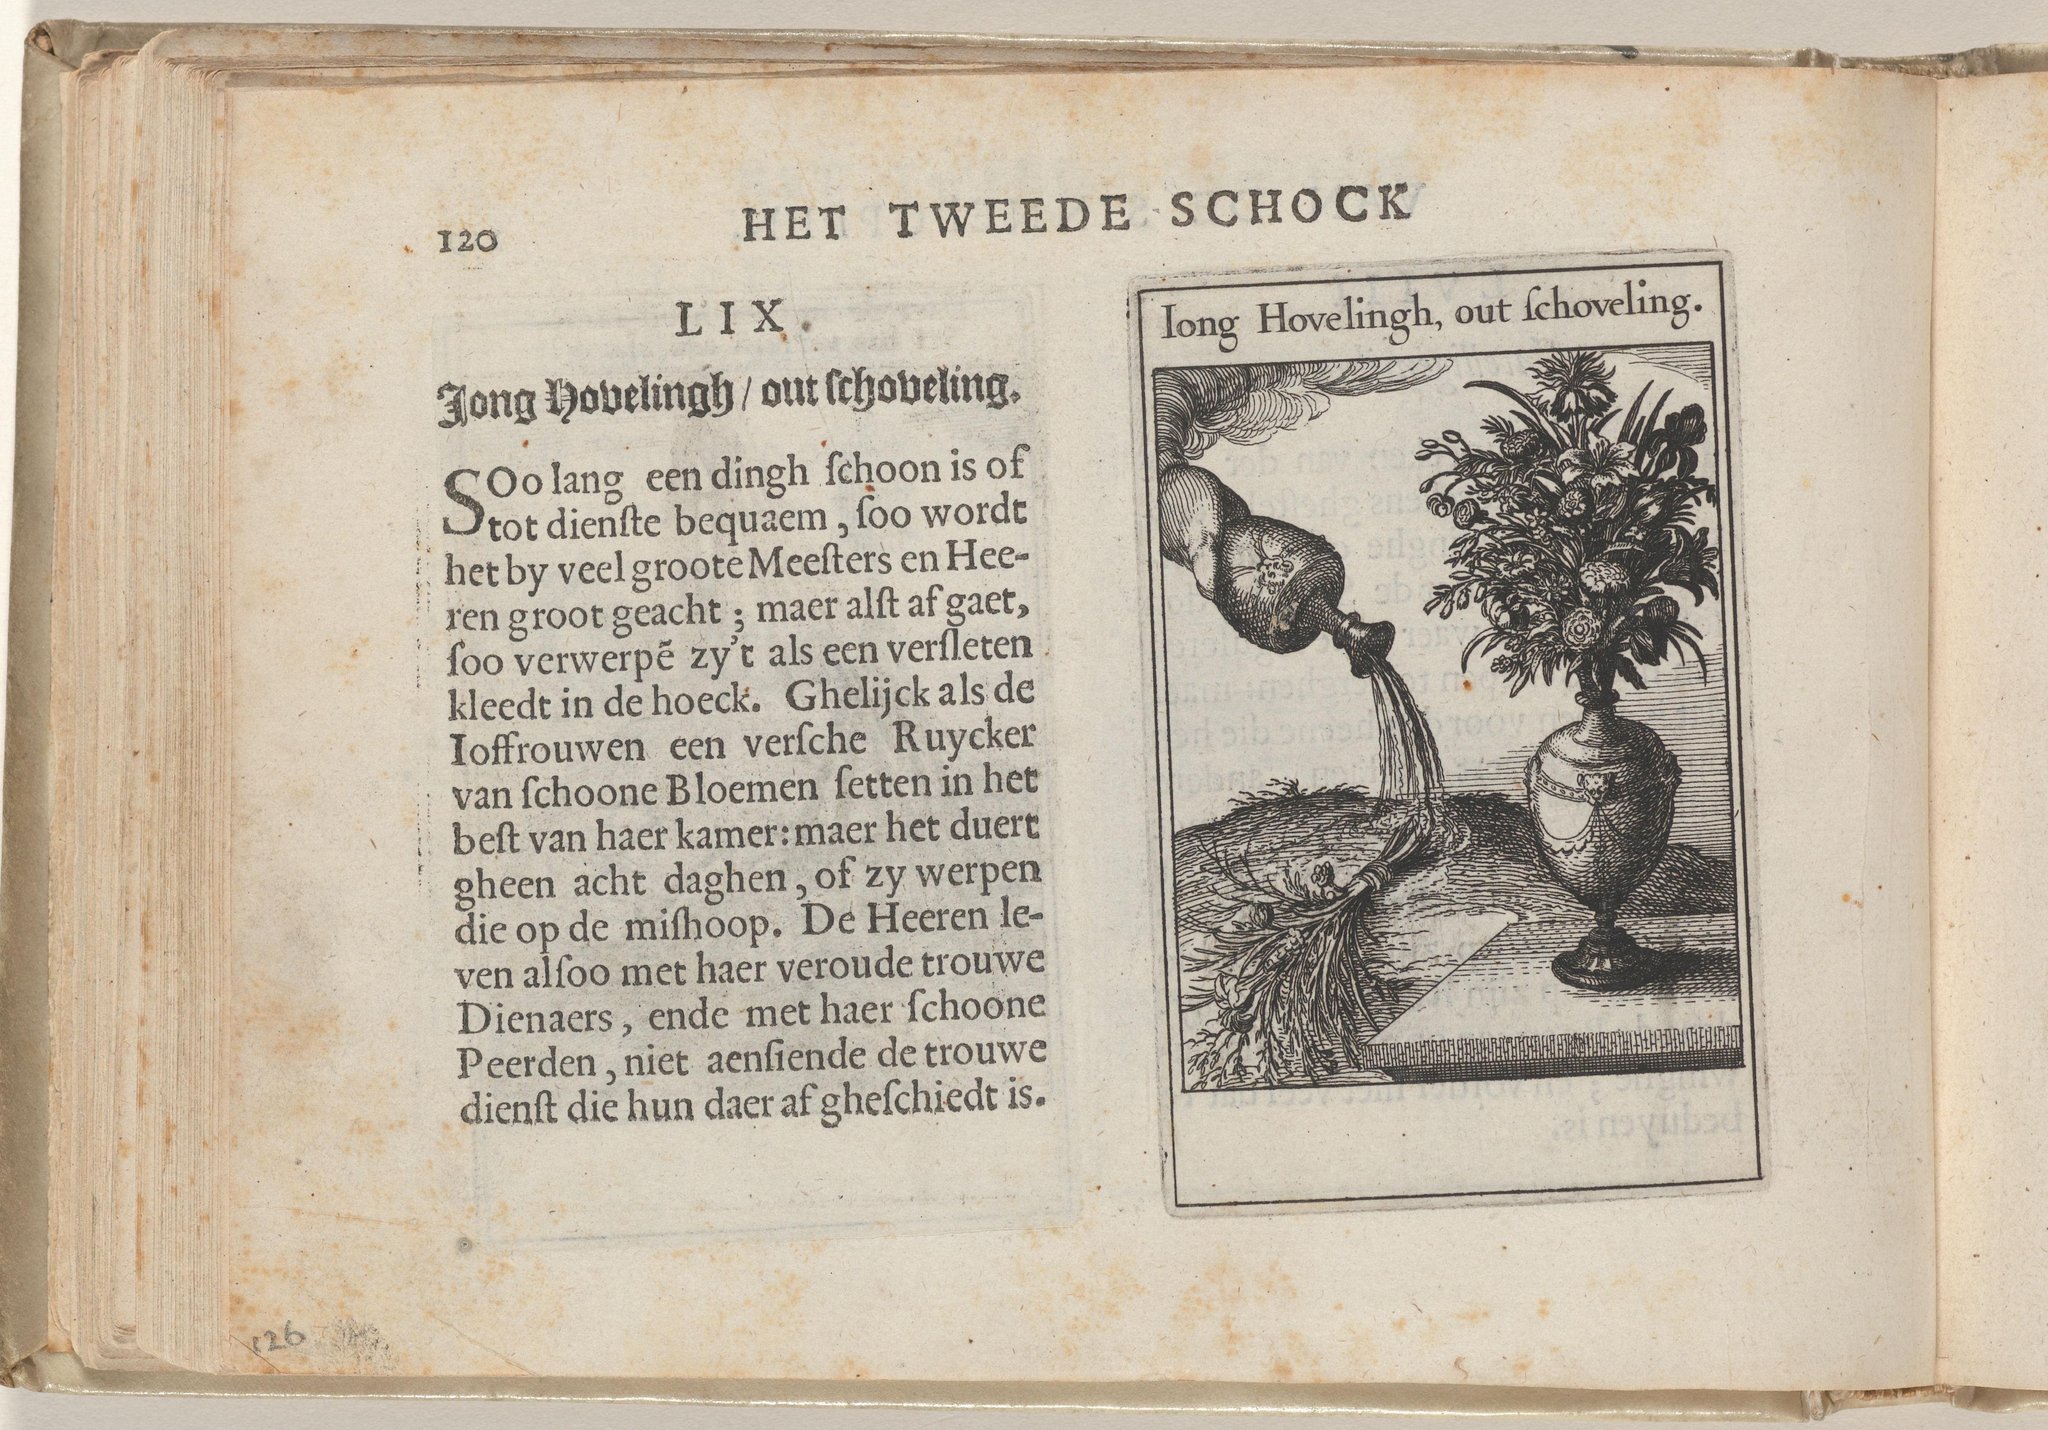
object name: print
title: LIX Iong Hovelingh, out schoveling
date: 1614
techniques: engraving, printing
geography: the hague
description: LIX Iong Hovelingh, out schoveling. Tweede schok. Onderdeel van 'Sinnepoppen', R. Visscher, 1614.